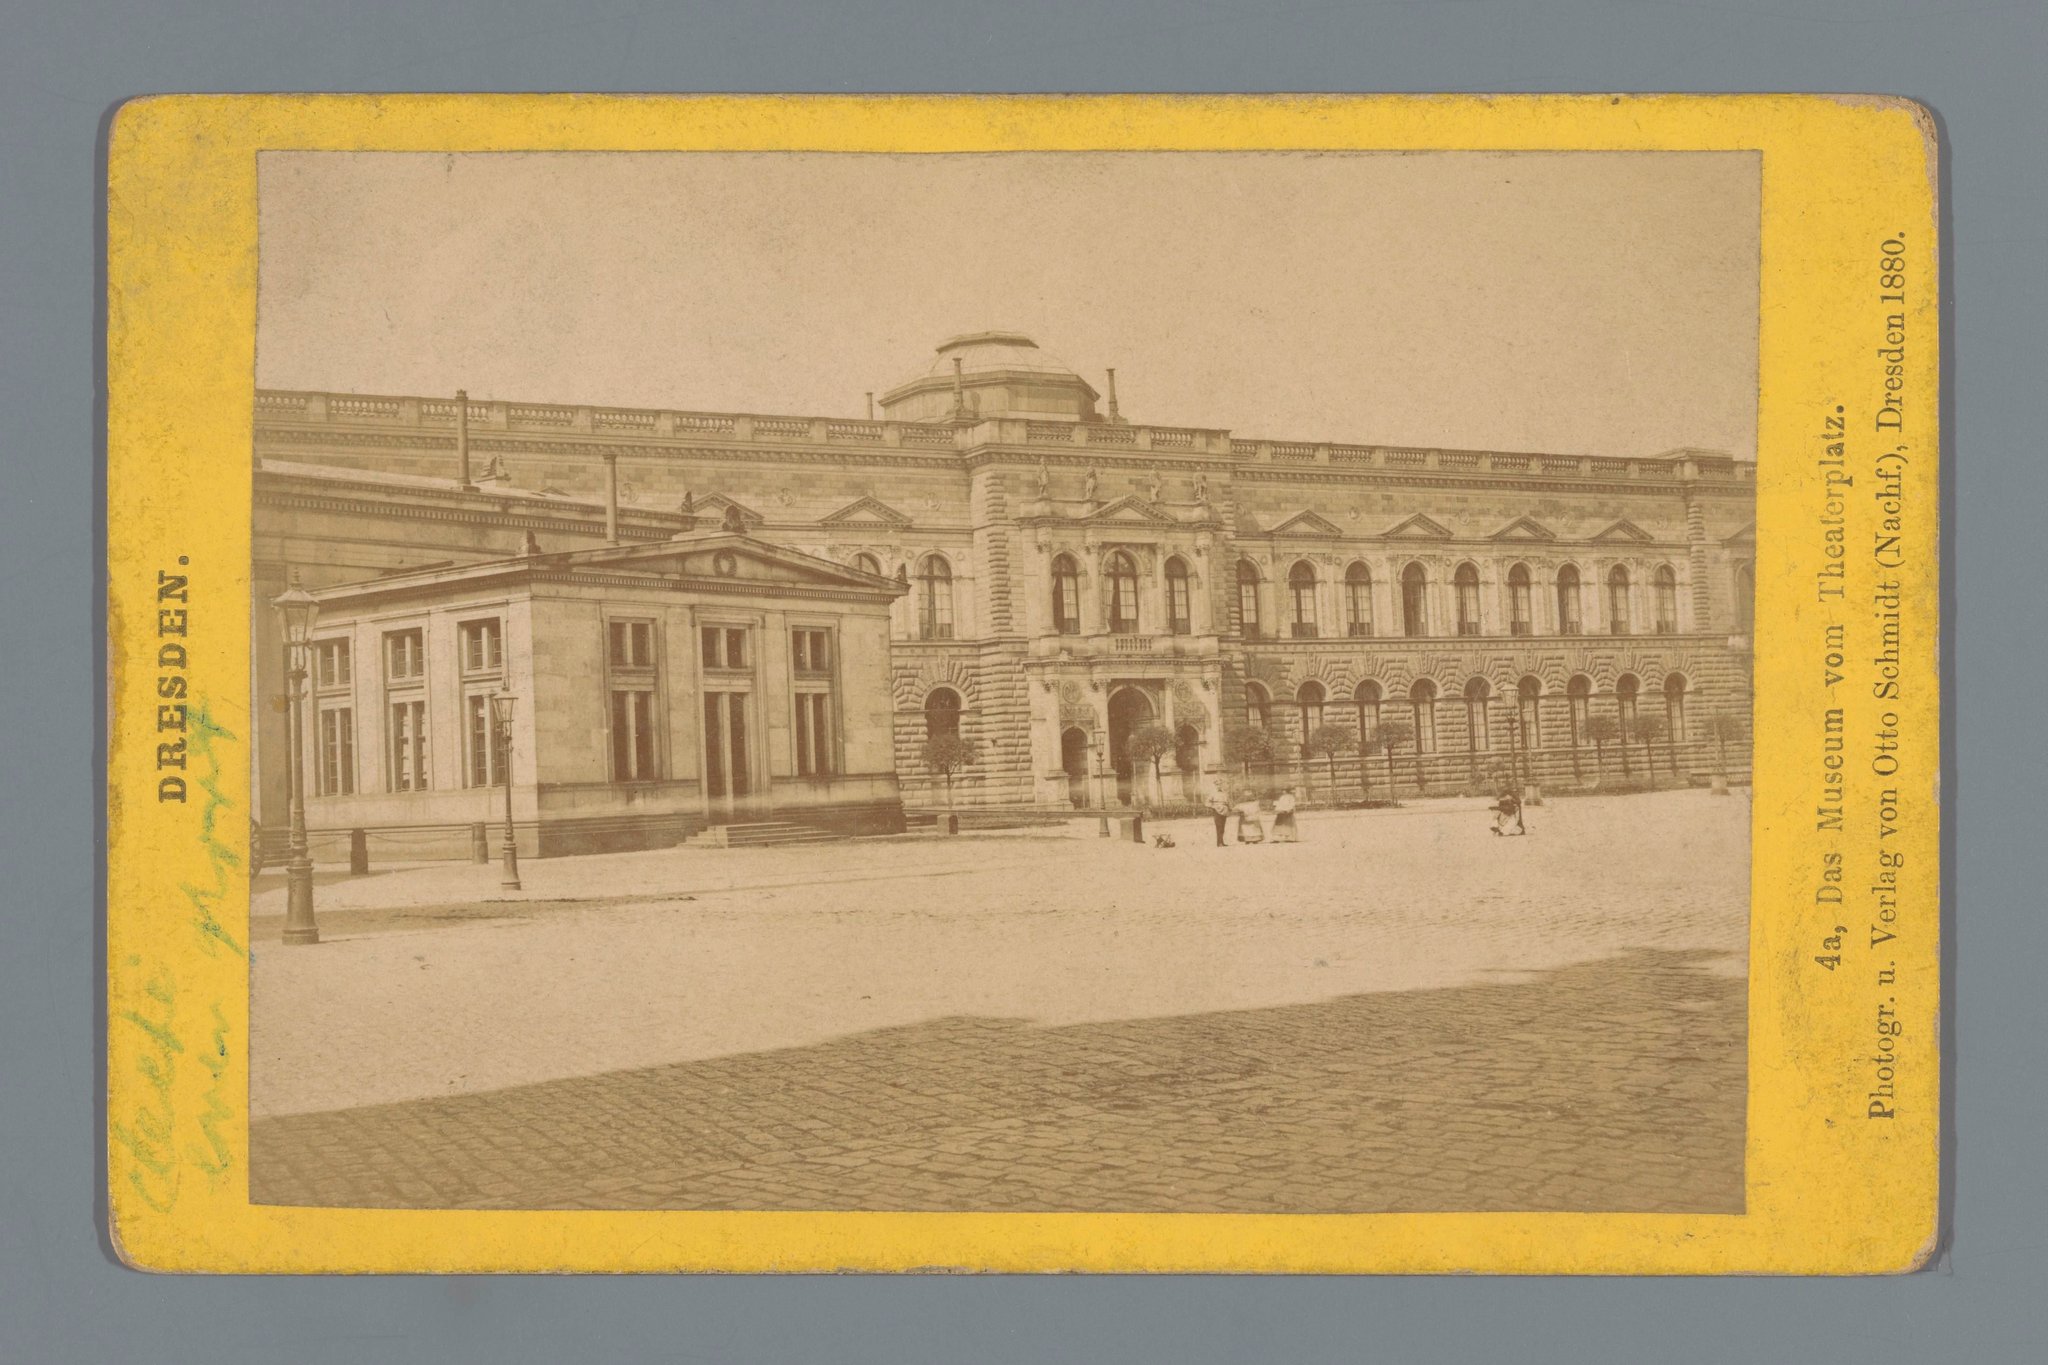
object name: cabinet photograph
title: Gezicht op museum De Zwinger in Dresden vanaf het Theaterplatz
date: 1880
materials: cardboard, photographic support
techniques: albumen print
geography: dresden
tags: palace, permanent exhibition, museum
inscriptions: annotation: ‘cliché even groot’, number: ‘4a’